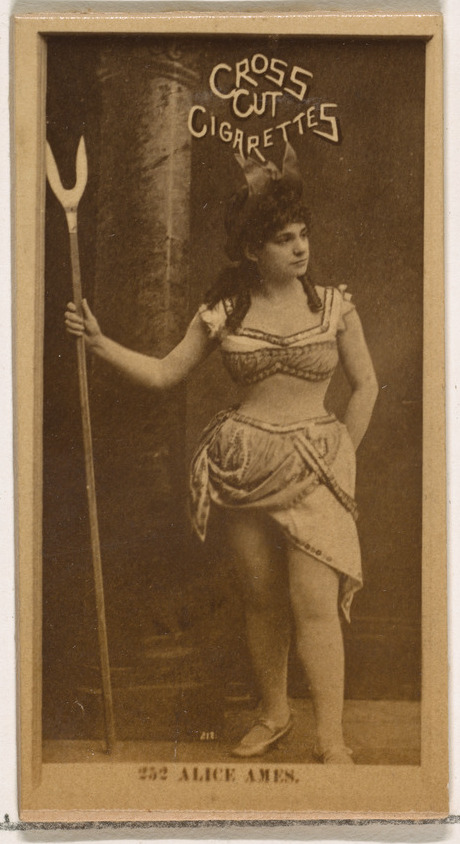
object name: print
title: Card Number 252, Alice Ames, from the Actors and Actresses series (N145-2) issued by Duke Sons & Co. to promote Cross Cut Cigarettes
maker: w. duke, sons & co.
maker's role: publisher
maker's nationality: american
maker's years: 1870-1920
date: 1880-1889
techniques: albumen silver print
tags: portraits,women,actresses